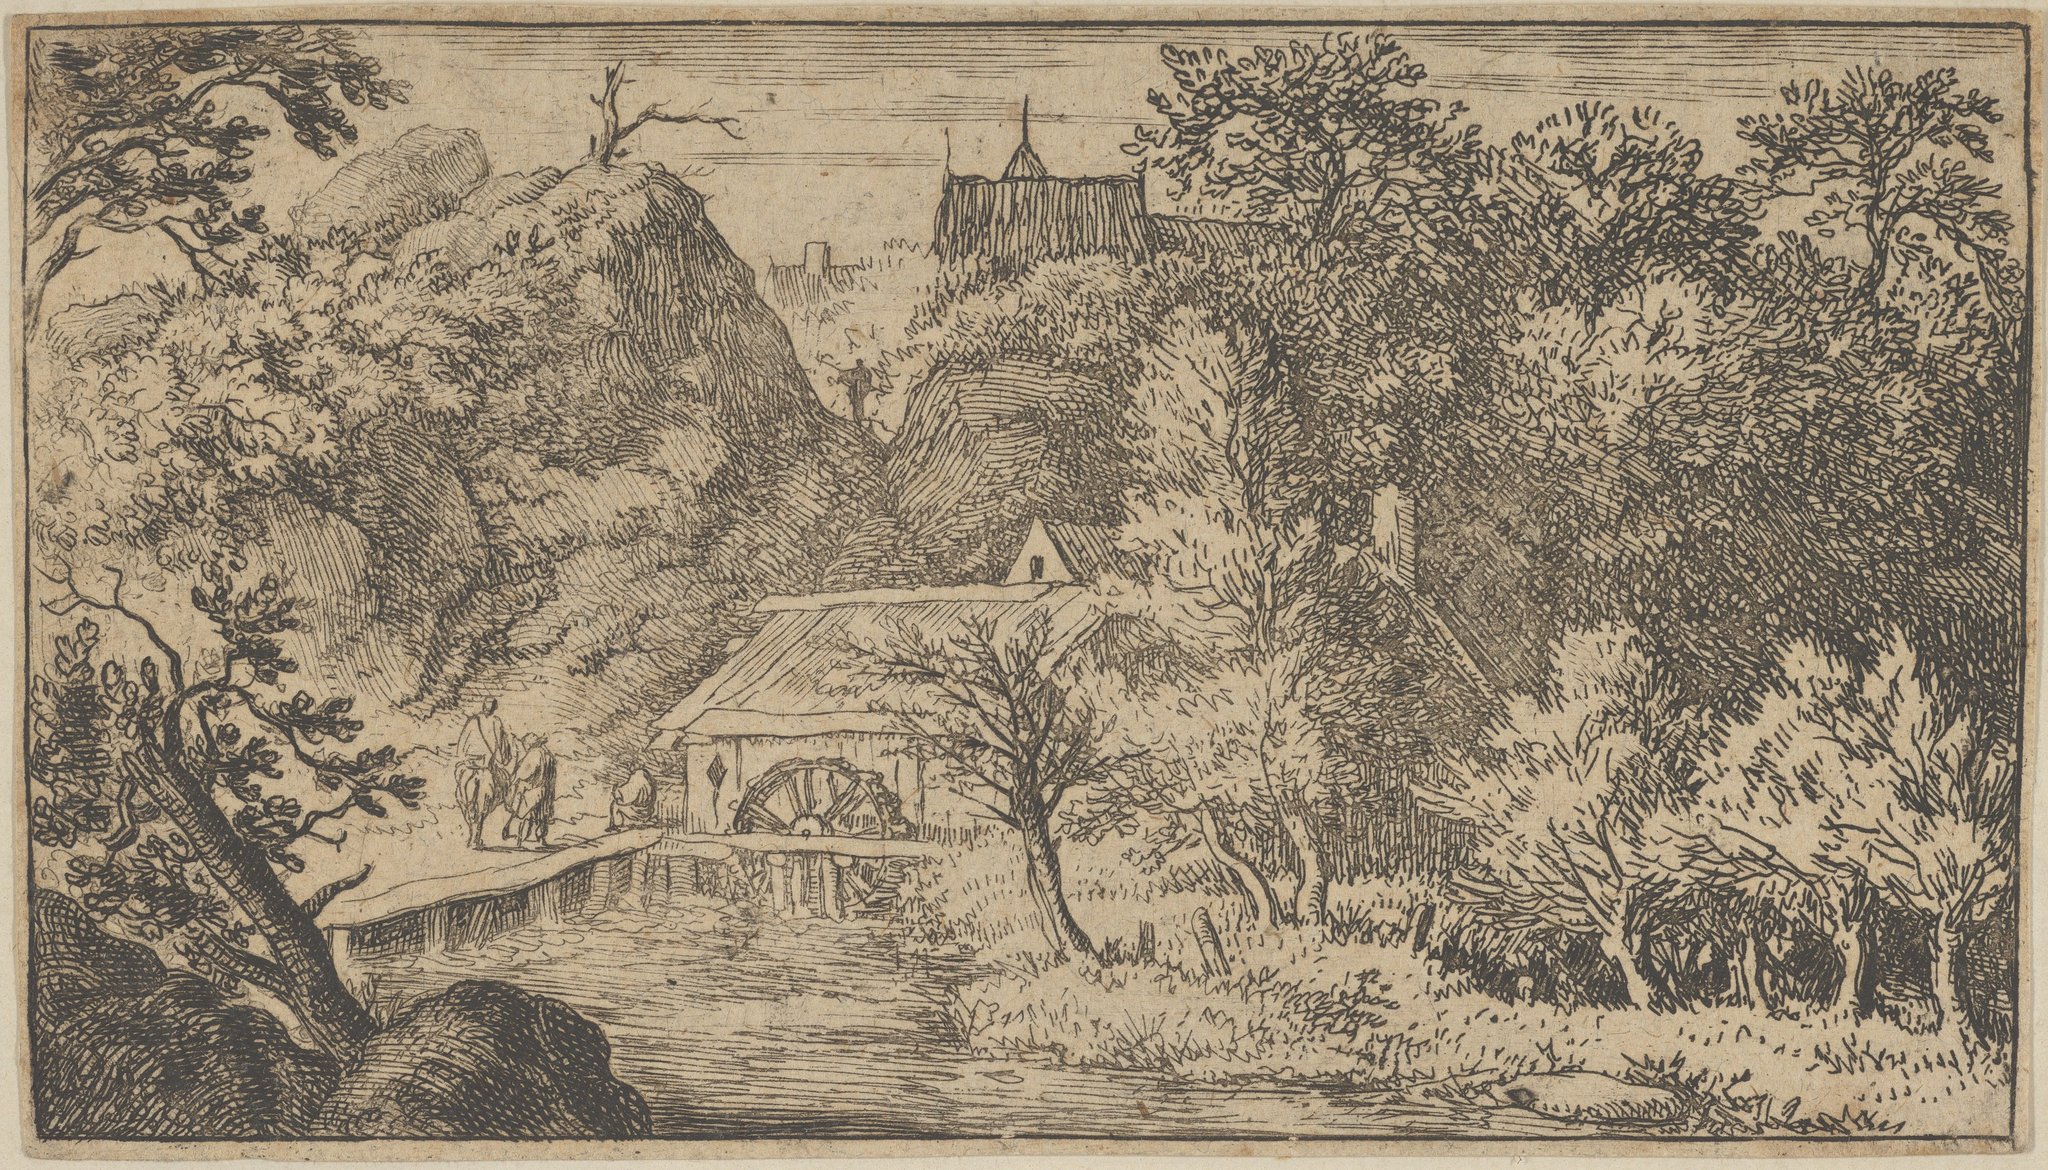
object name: print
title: The Watermill at the Foot of the Mountain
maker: allart van everdingen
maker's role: artist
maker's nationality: dutch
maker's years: 1621-1675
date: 1621-1675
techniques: engraving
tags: watermills,mountains,trees